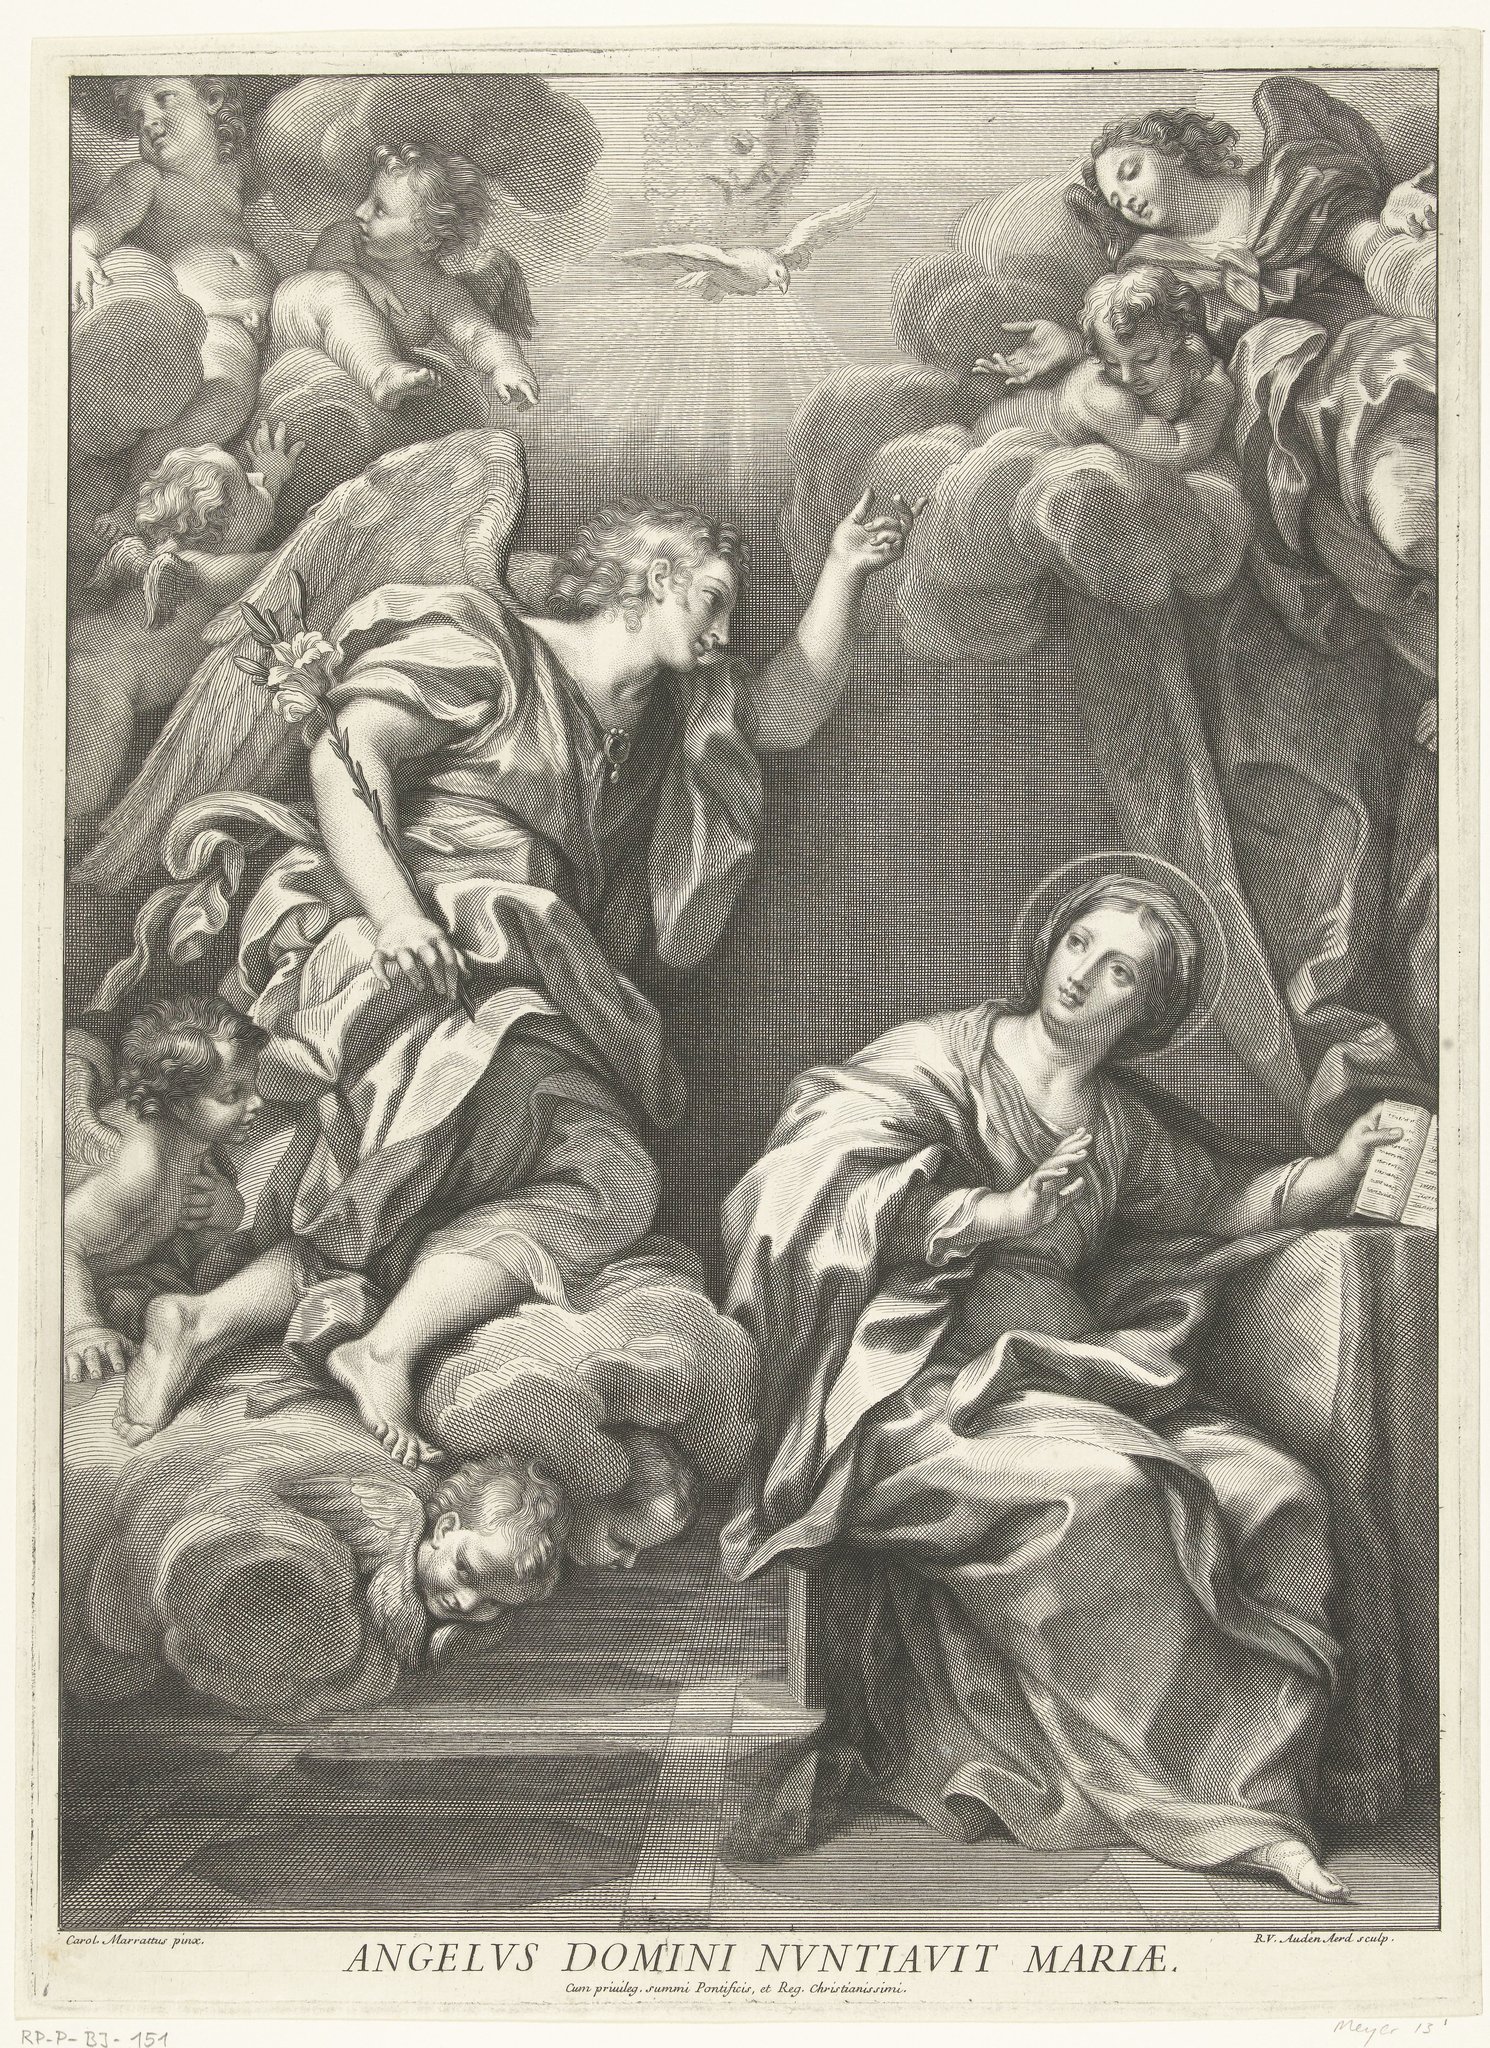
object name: print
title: Angelvs Domini Nvntiavit Mariae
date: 1685-1723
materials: paper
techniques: engraving, etching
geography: rome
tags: the annunciation: mary sitting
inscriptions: collector's mark: Lugt 240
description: Maria zit aan een tafel en leest een boek. De engel Gabriël zweeft op een wolkenbed en brengt haar de boodschap dat zij Christus zal baren. In zijn hand houdt hij een lelie als symbool voor Marias reinheid. Boven Gabriël vliegt een duif, het symbool voor de Heilige Geest die neerdaalt op Maria.